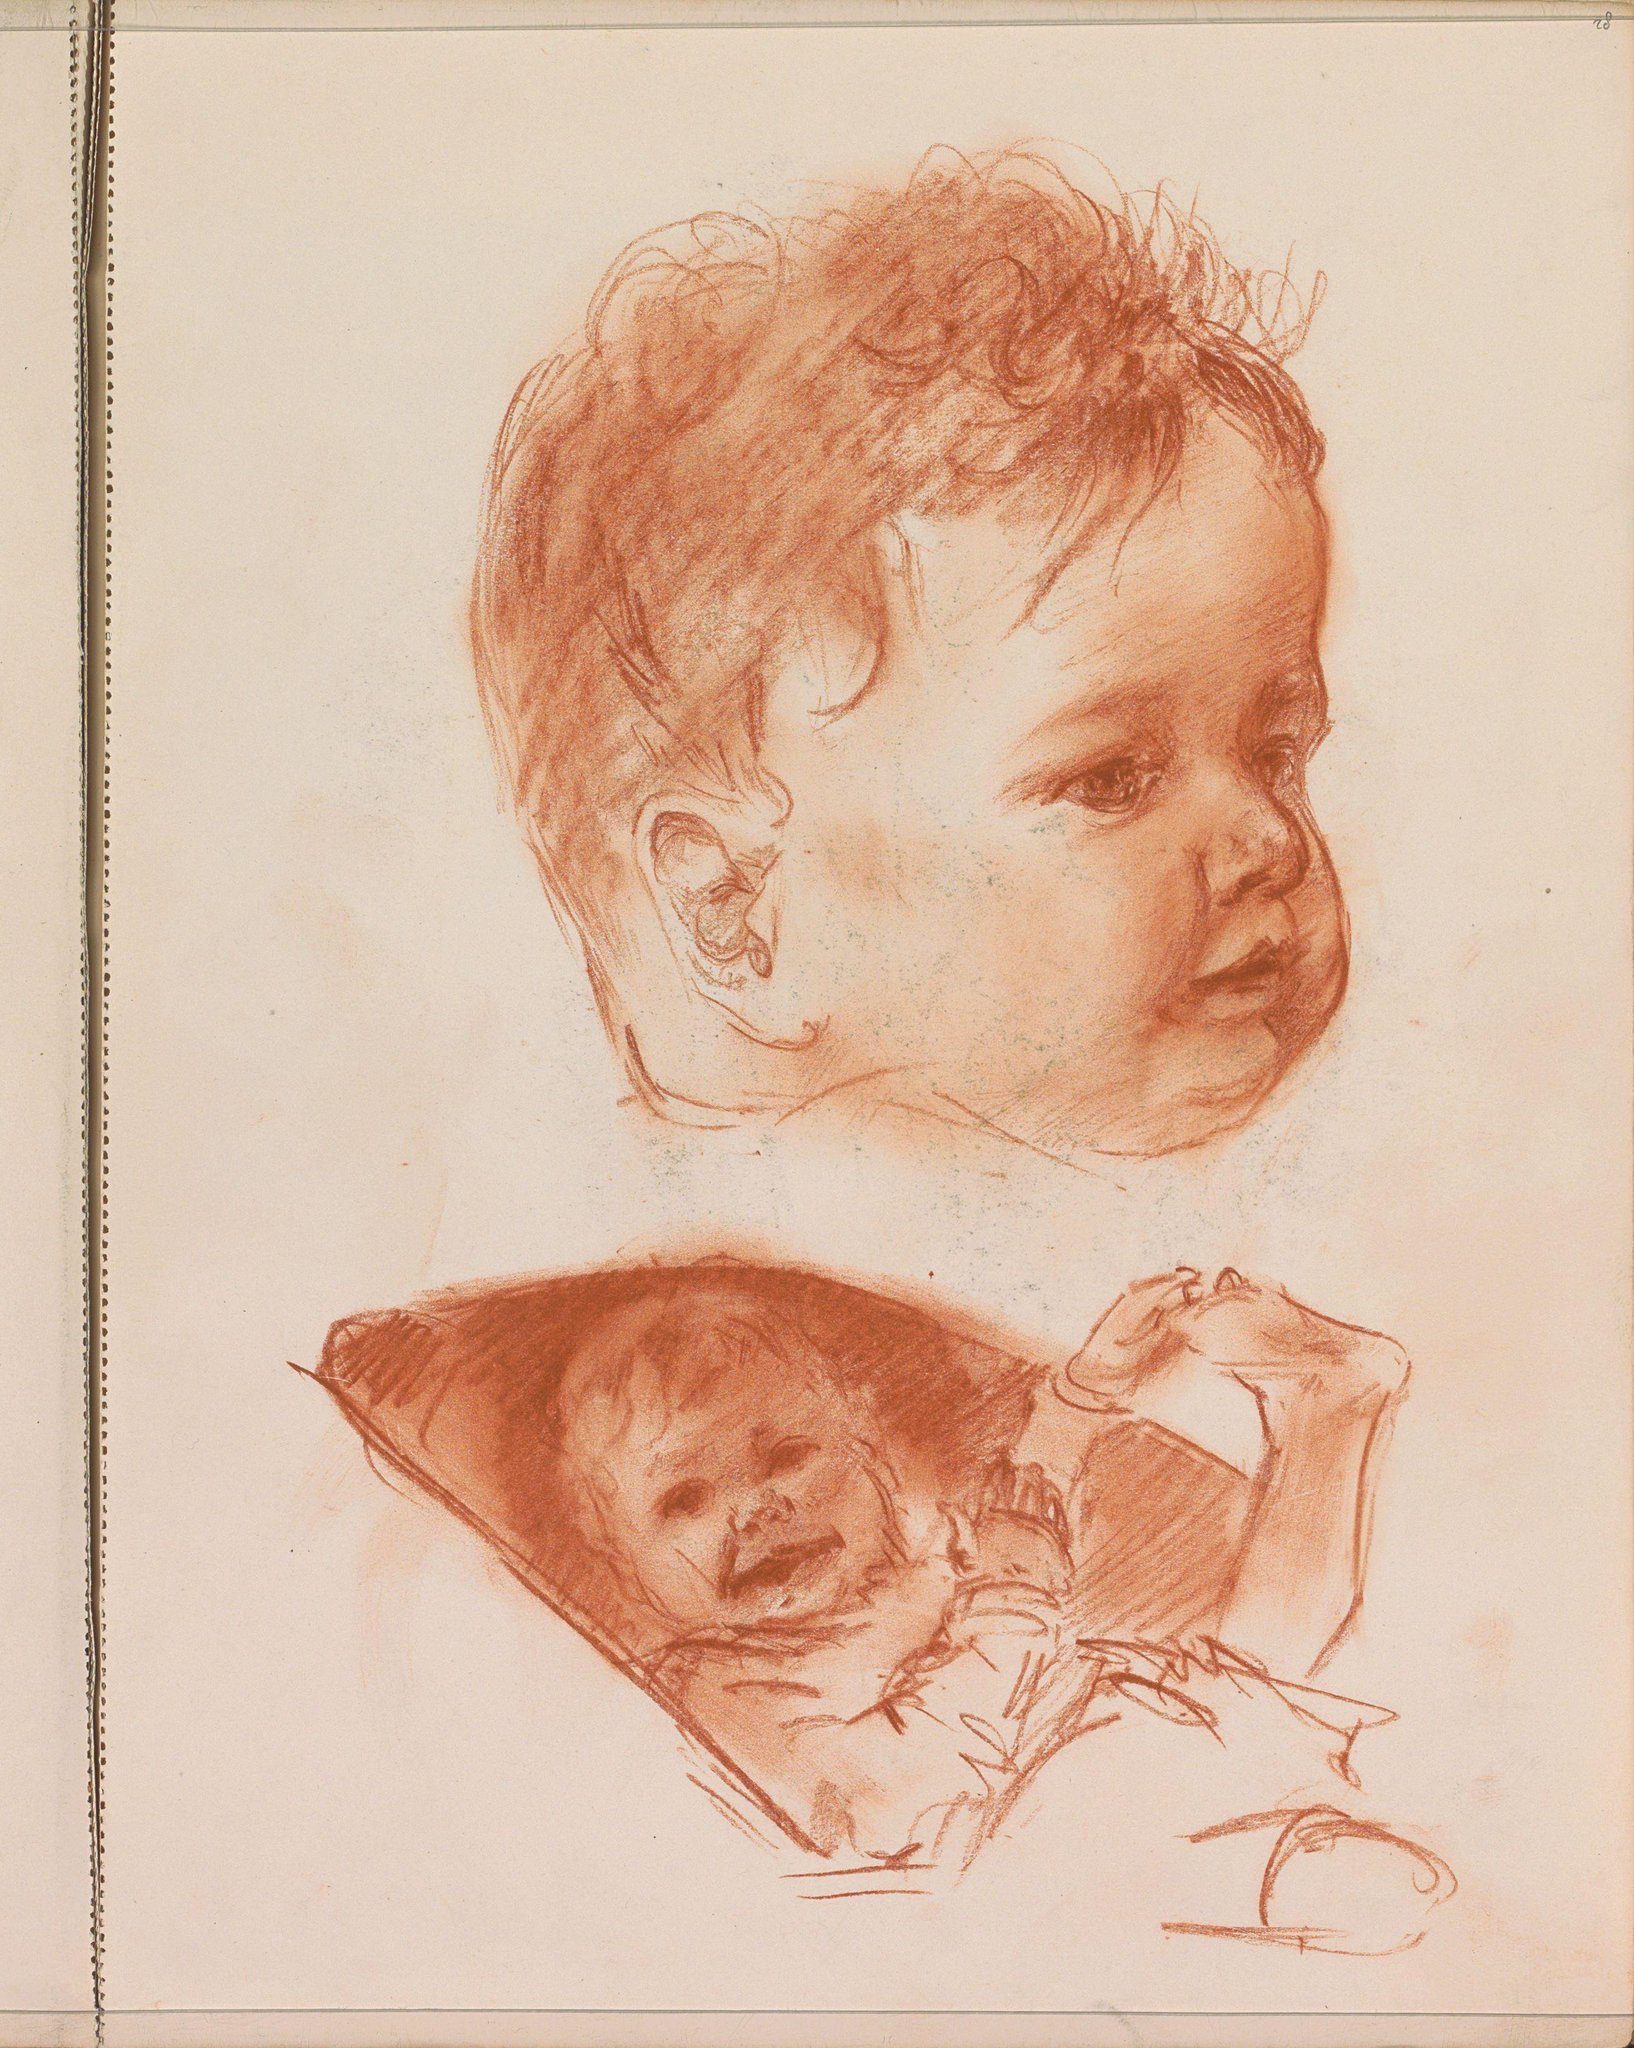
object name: sketchbook leaf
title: Lachend kind in een wieg en een kop van een kind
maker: otto verhagen (i)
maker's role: draughtsman, print maker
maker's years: 1885-1951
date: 1917-1919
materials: chalk, paper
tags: child, cradle, crib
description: Het kind in de wieg heeft een voet in de lucht gestoken. Pagina 28 uit een schetsboek met 28 bladen.